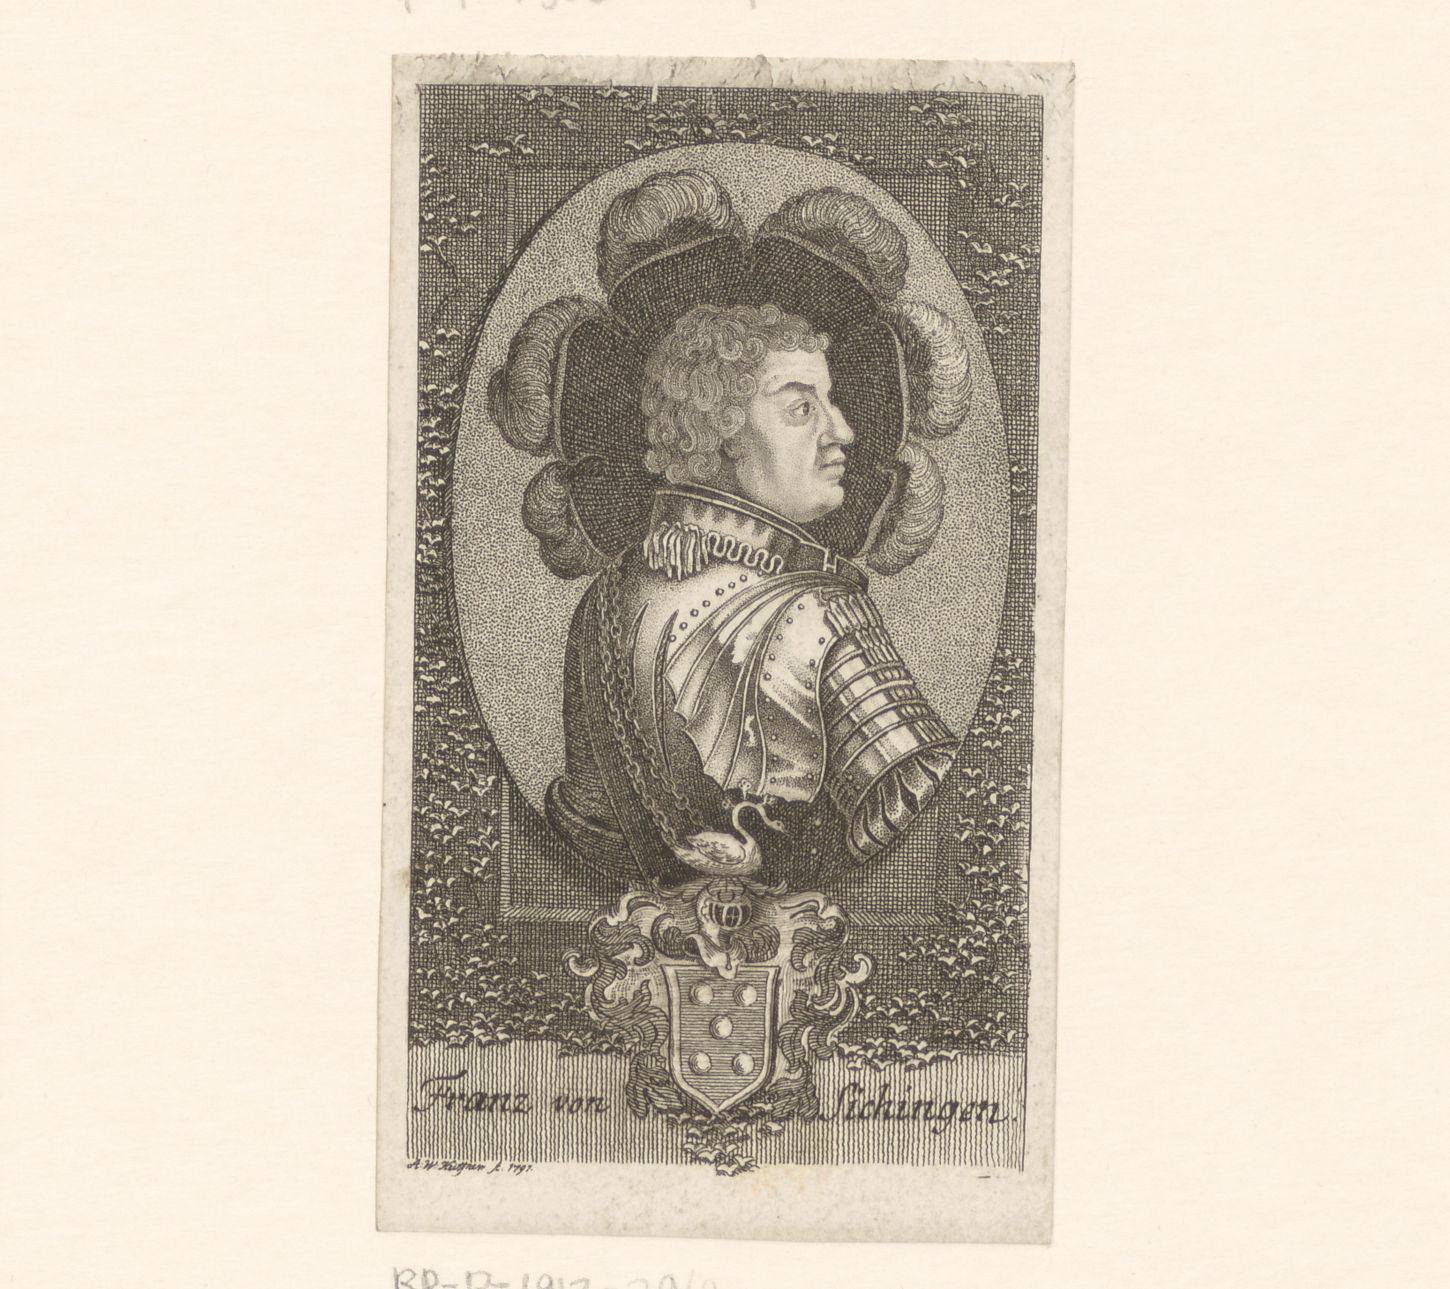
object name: print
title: Portret van Franz von Sickingen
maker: abraham wolfgang küfner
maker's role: print maker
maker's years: 1760-1817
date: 1797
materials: paper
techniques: etching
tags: historical persons, officer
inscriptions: collector's mark: Lugt 2228